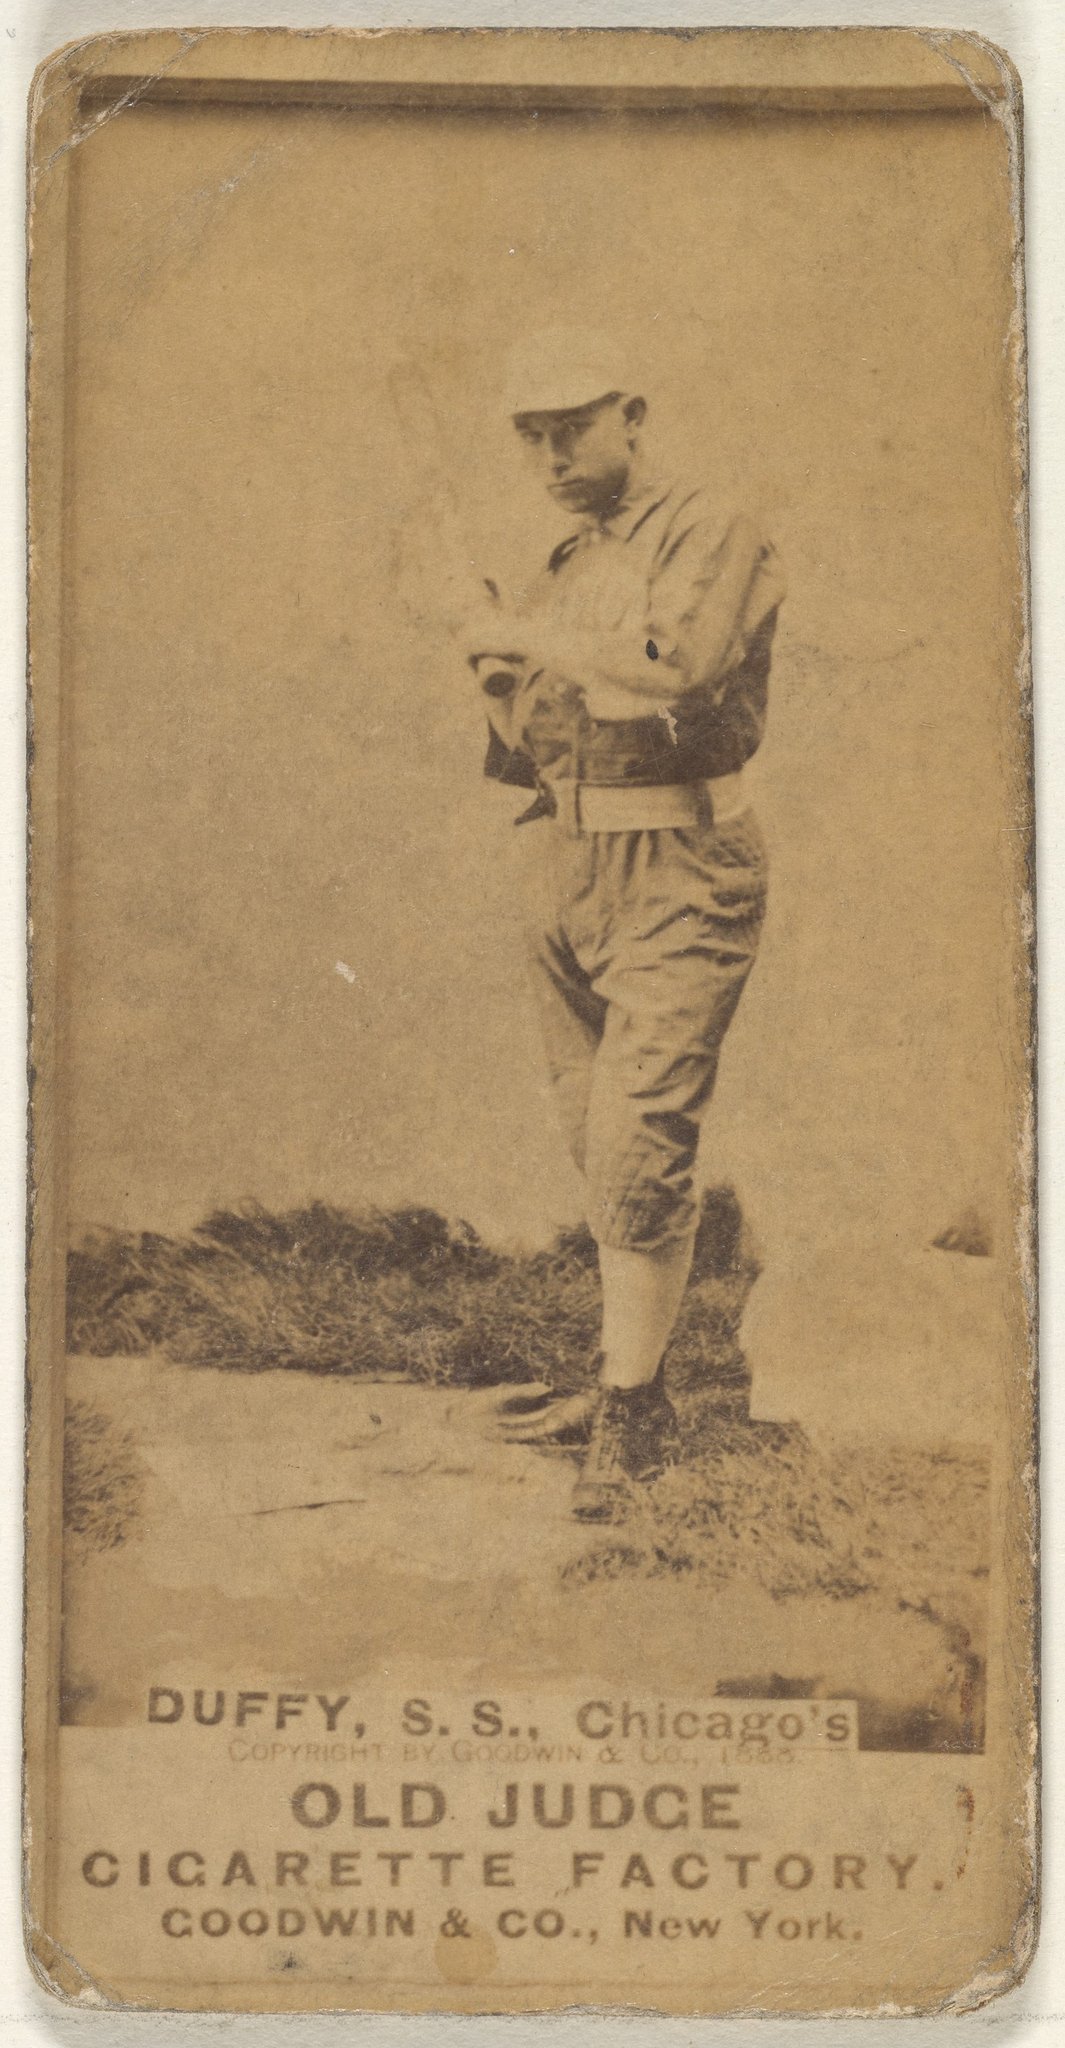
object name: baseball card, photograph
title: Duffy, Shortstop, Chicago, from the Old Judge series (N172) for Old Judge Cigarettes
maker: goodwin & company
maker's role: publisher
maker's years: 1850-1950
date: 1887-1890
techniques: albumen silver print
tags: men,portraits,baseball,athletes